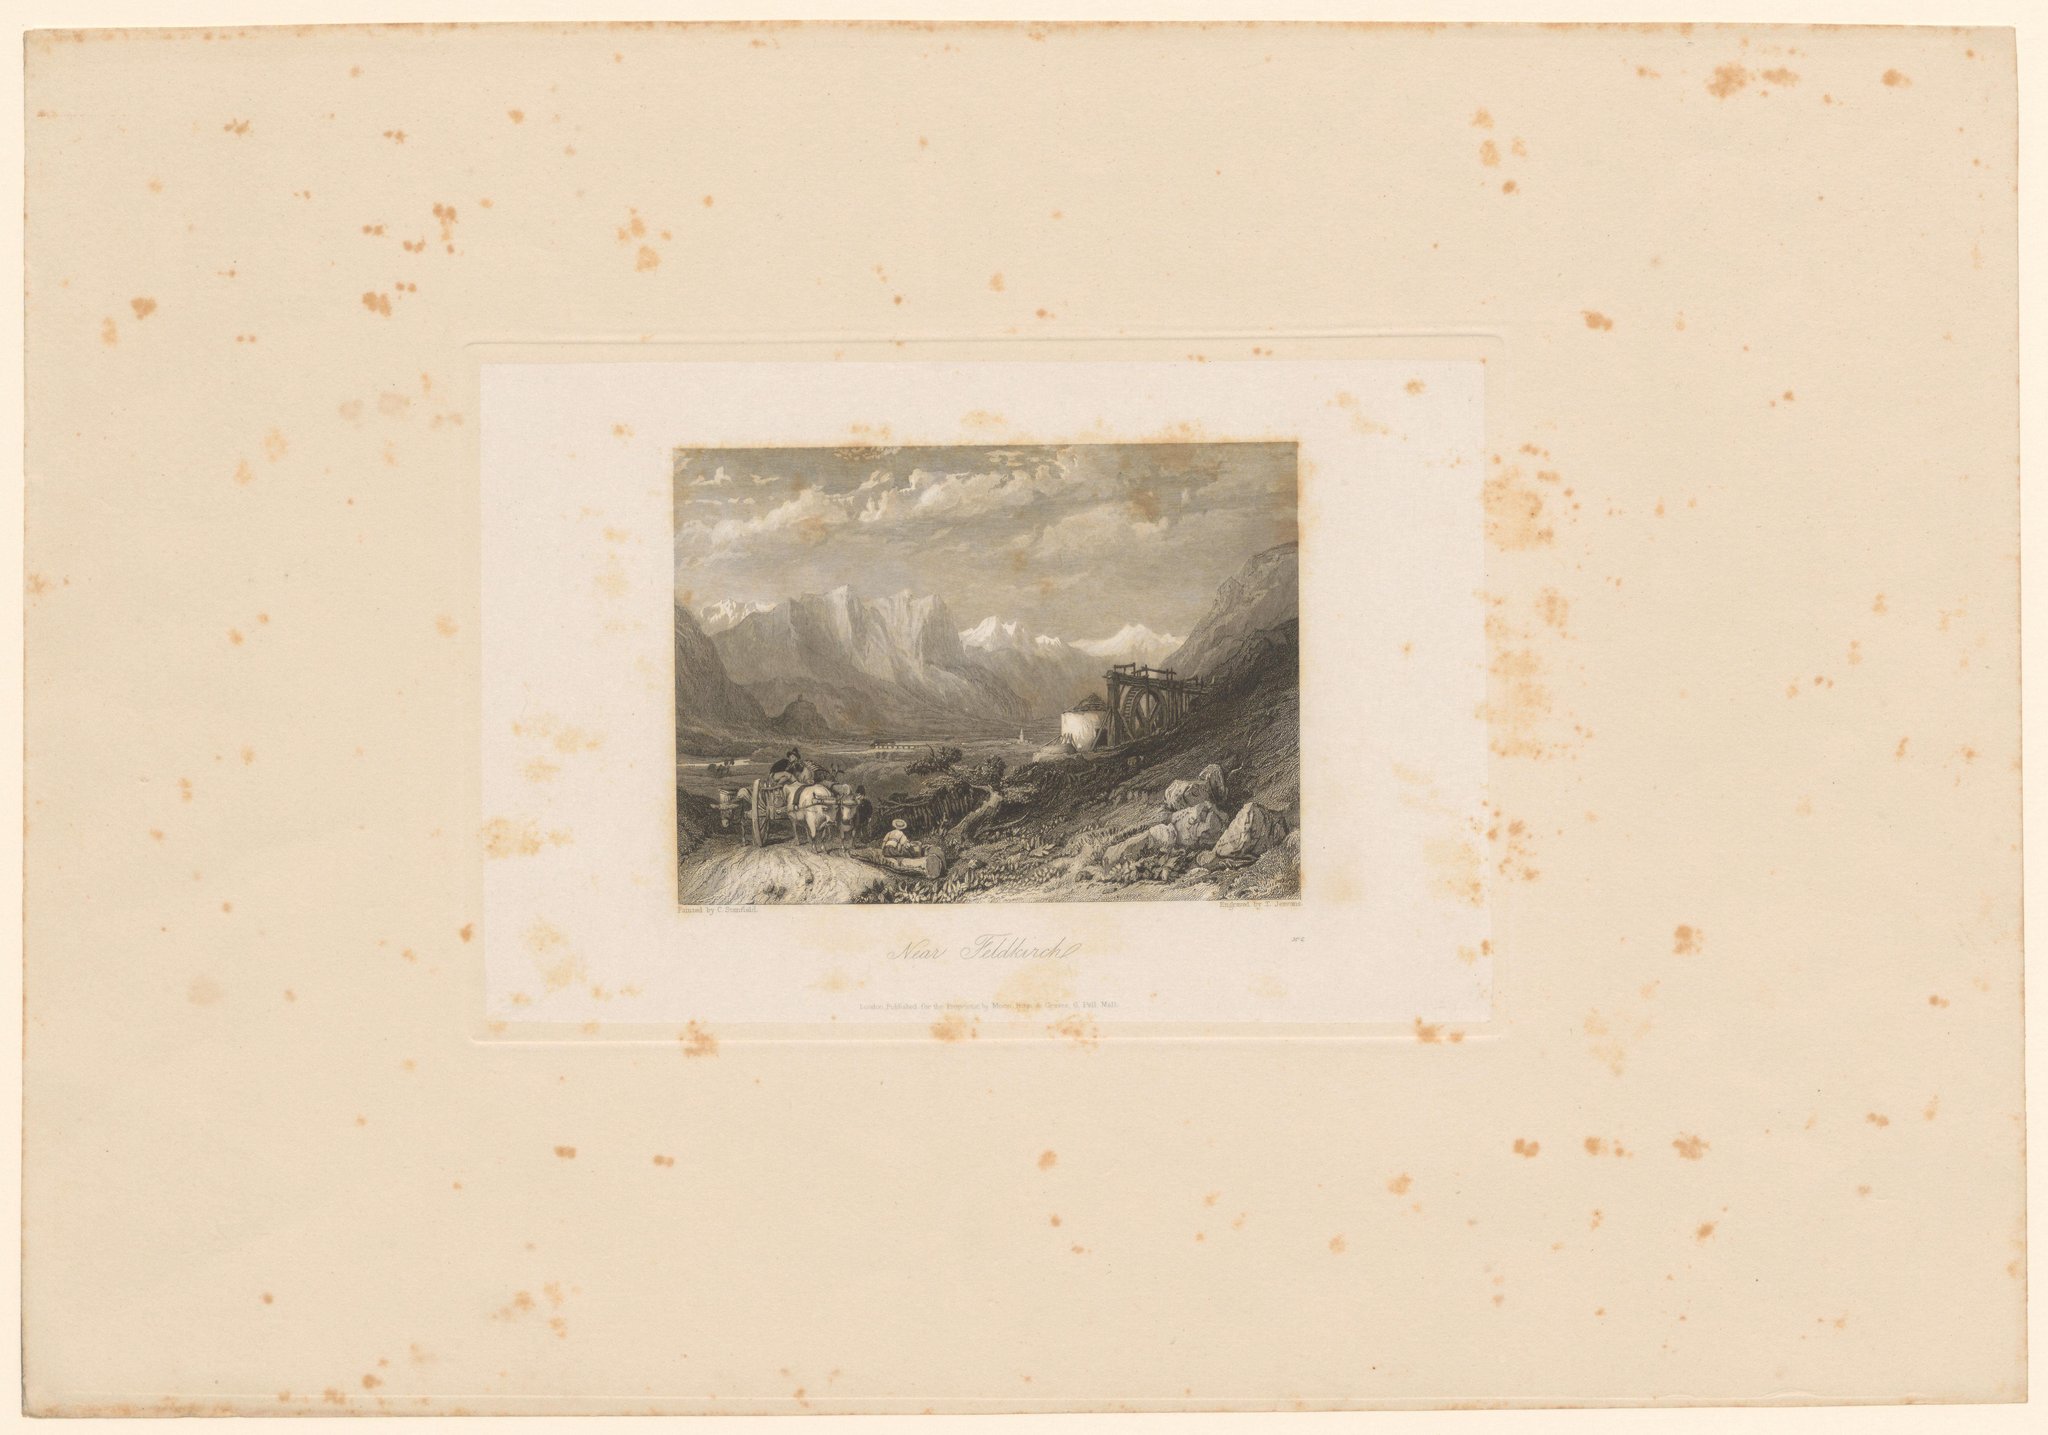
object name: print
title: Near Feldkrich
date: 1832-1833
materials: paper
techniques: engraving, etching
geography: london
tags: (high) hill (+ landscape with figures, staffage)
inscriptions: collector's mark: Lugt 2228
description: Prent is mogelijk gebruikt in: Ritchie, Leitch. Heath's Picturesque Annual (...). Londen: Longman, Rees, Orme, Brown & Green, 1832.